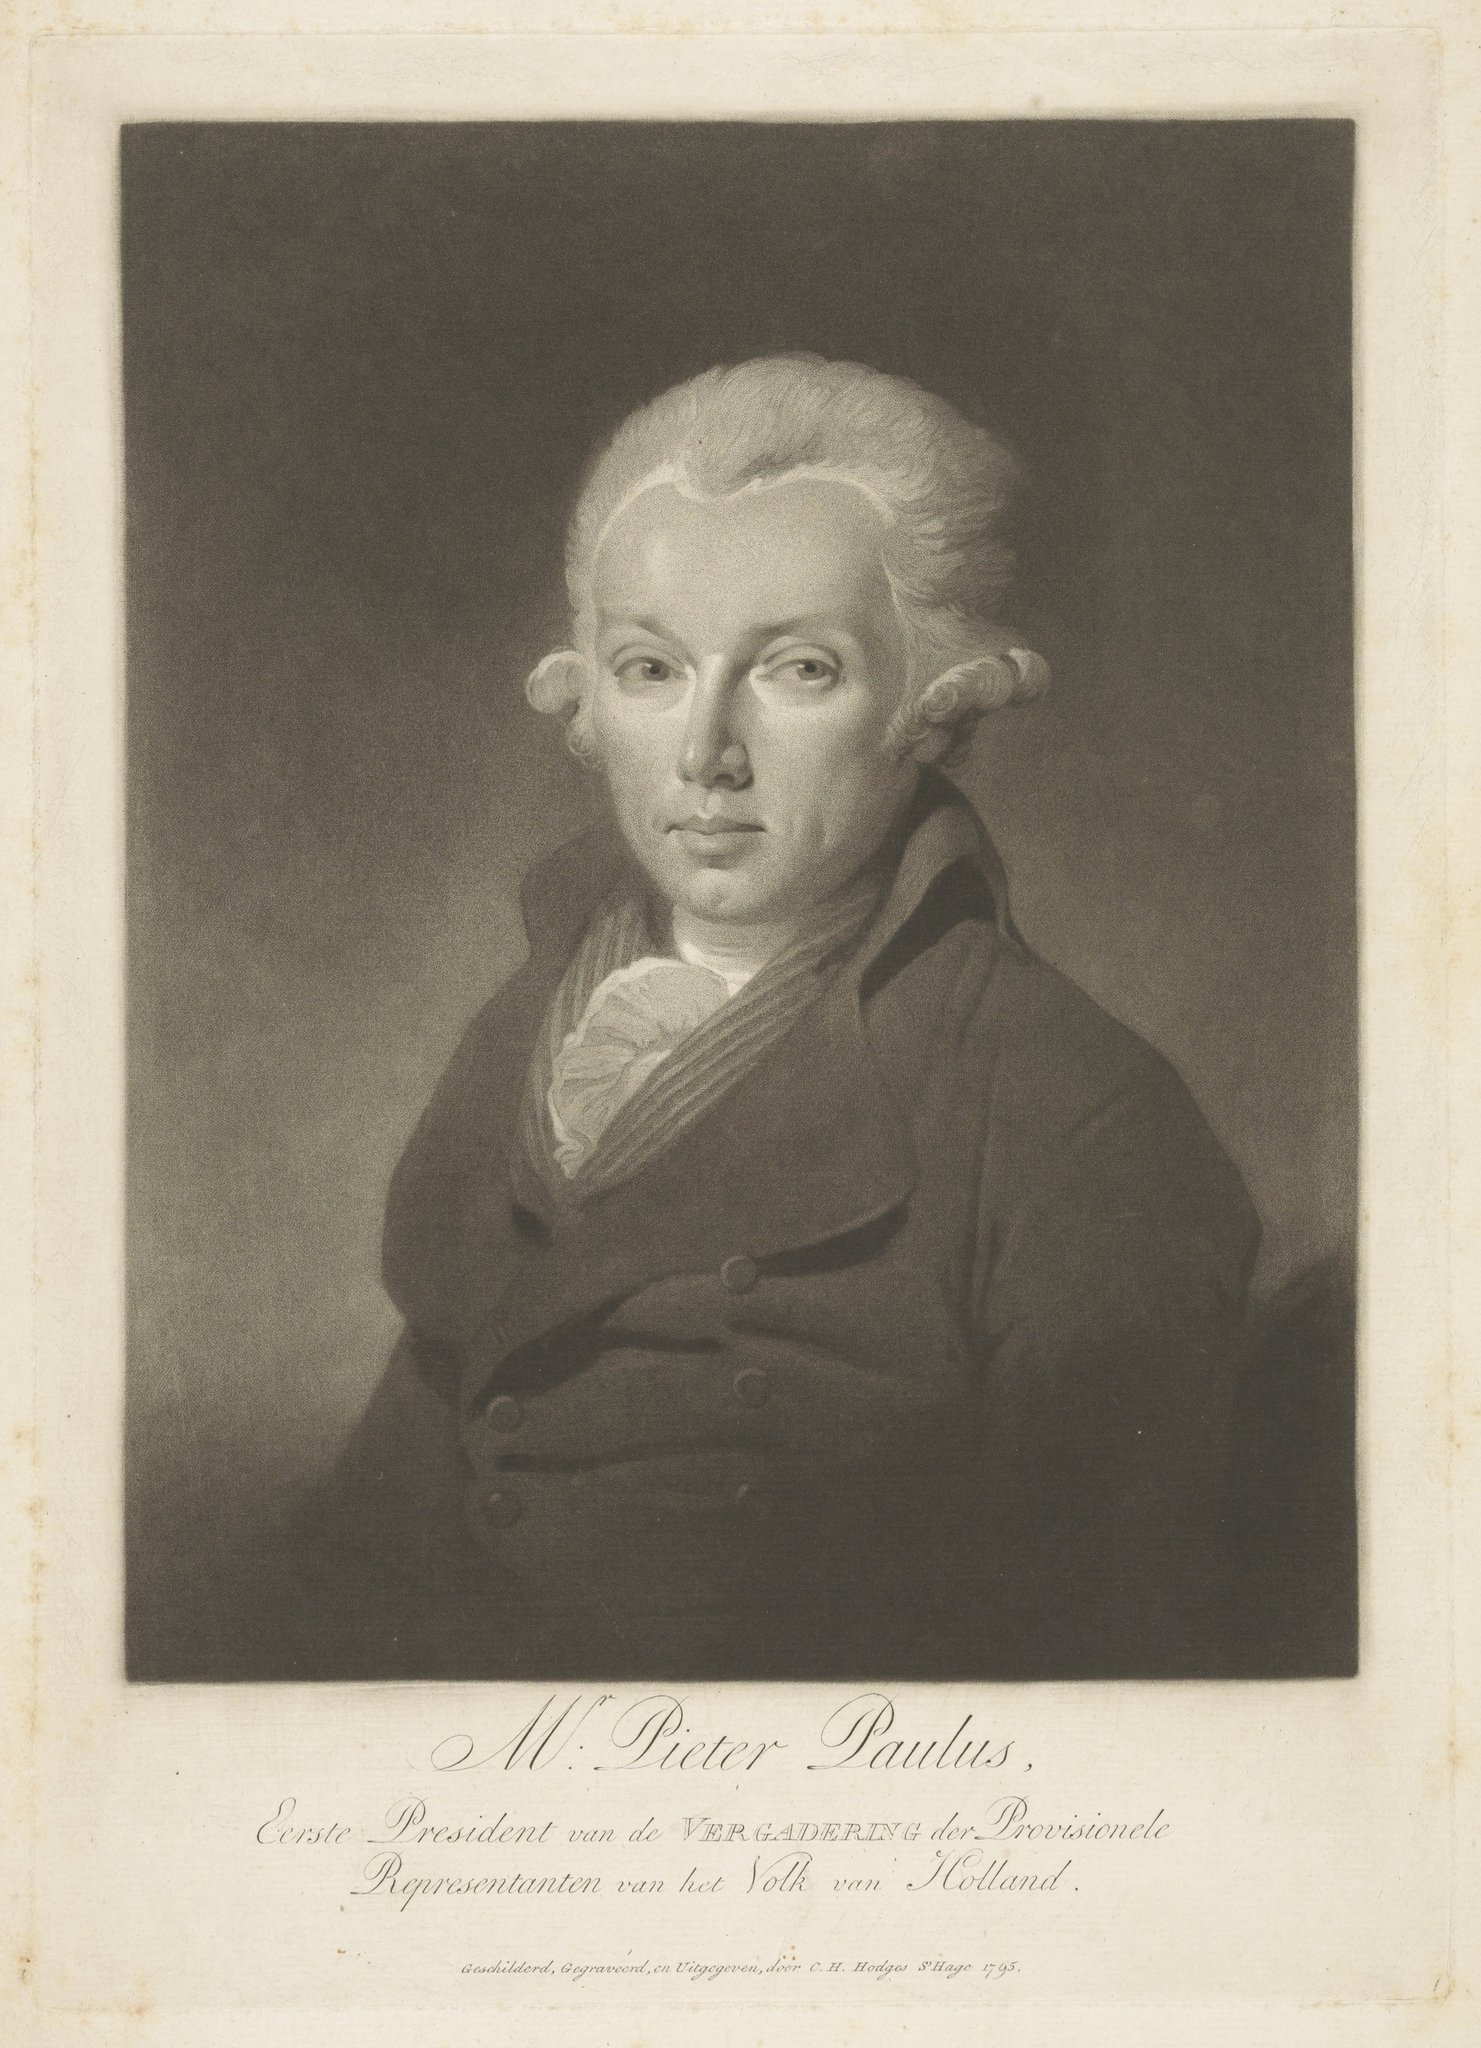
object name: print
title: Portret van Pieter Paulus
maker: charles howard hodges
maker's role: draughtsman, painter, print maker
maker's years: 1764-1837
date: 1795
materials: paper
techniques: mezzotint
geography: the hague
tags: pieter paulus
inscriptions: date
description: Portret van advocaat en politicus Pieter Paulus. In de ondermarge zijn naam en titel.